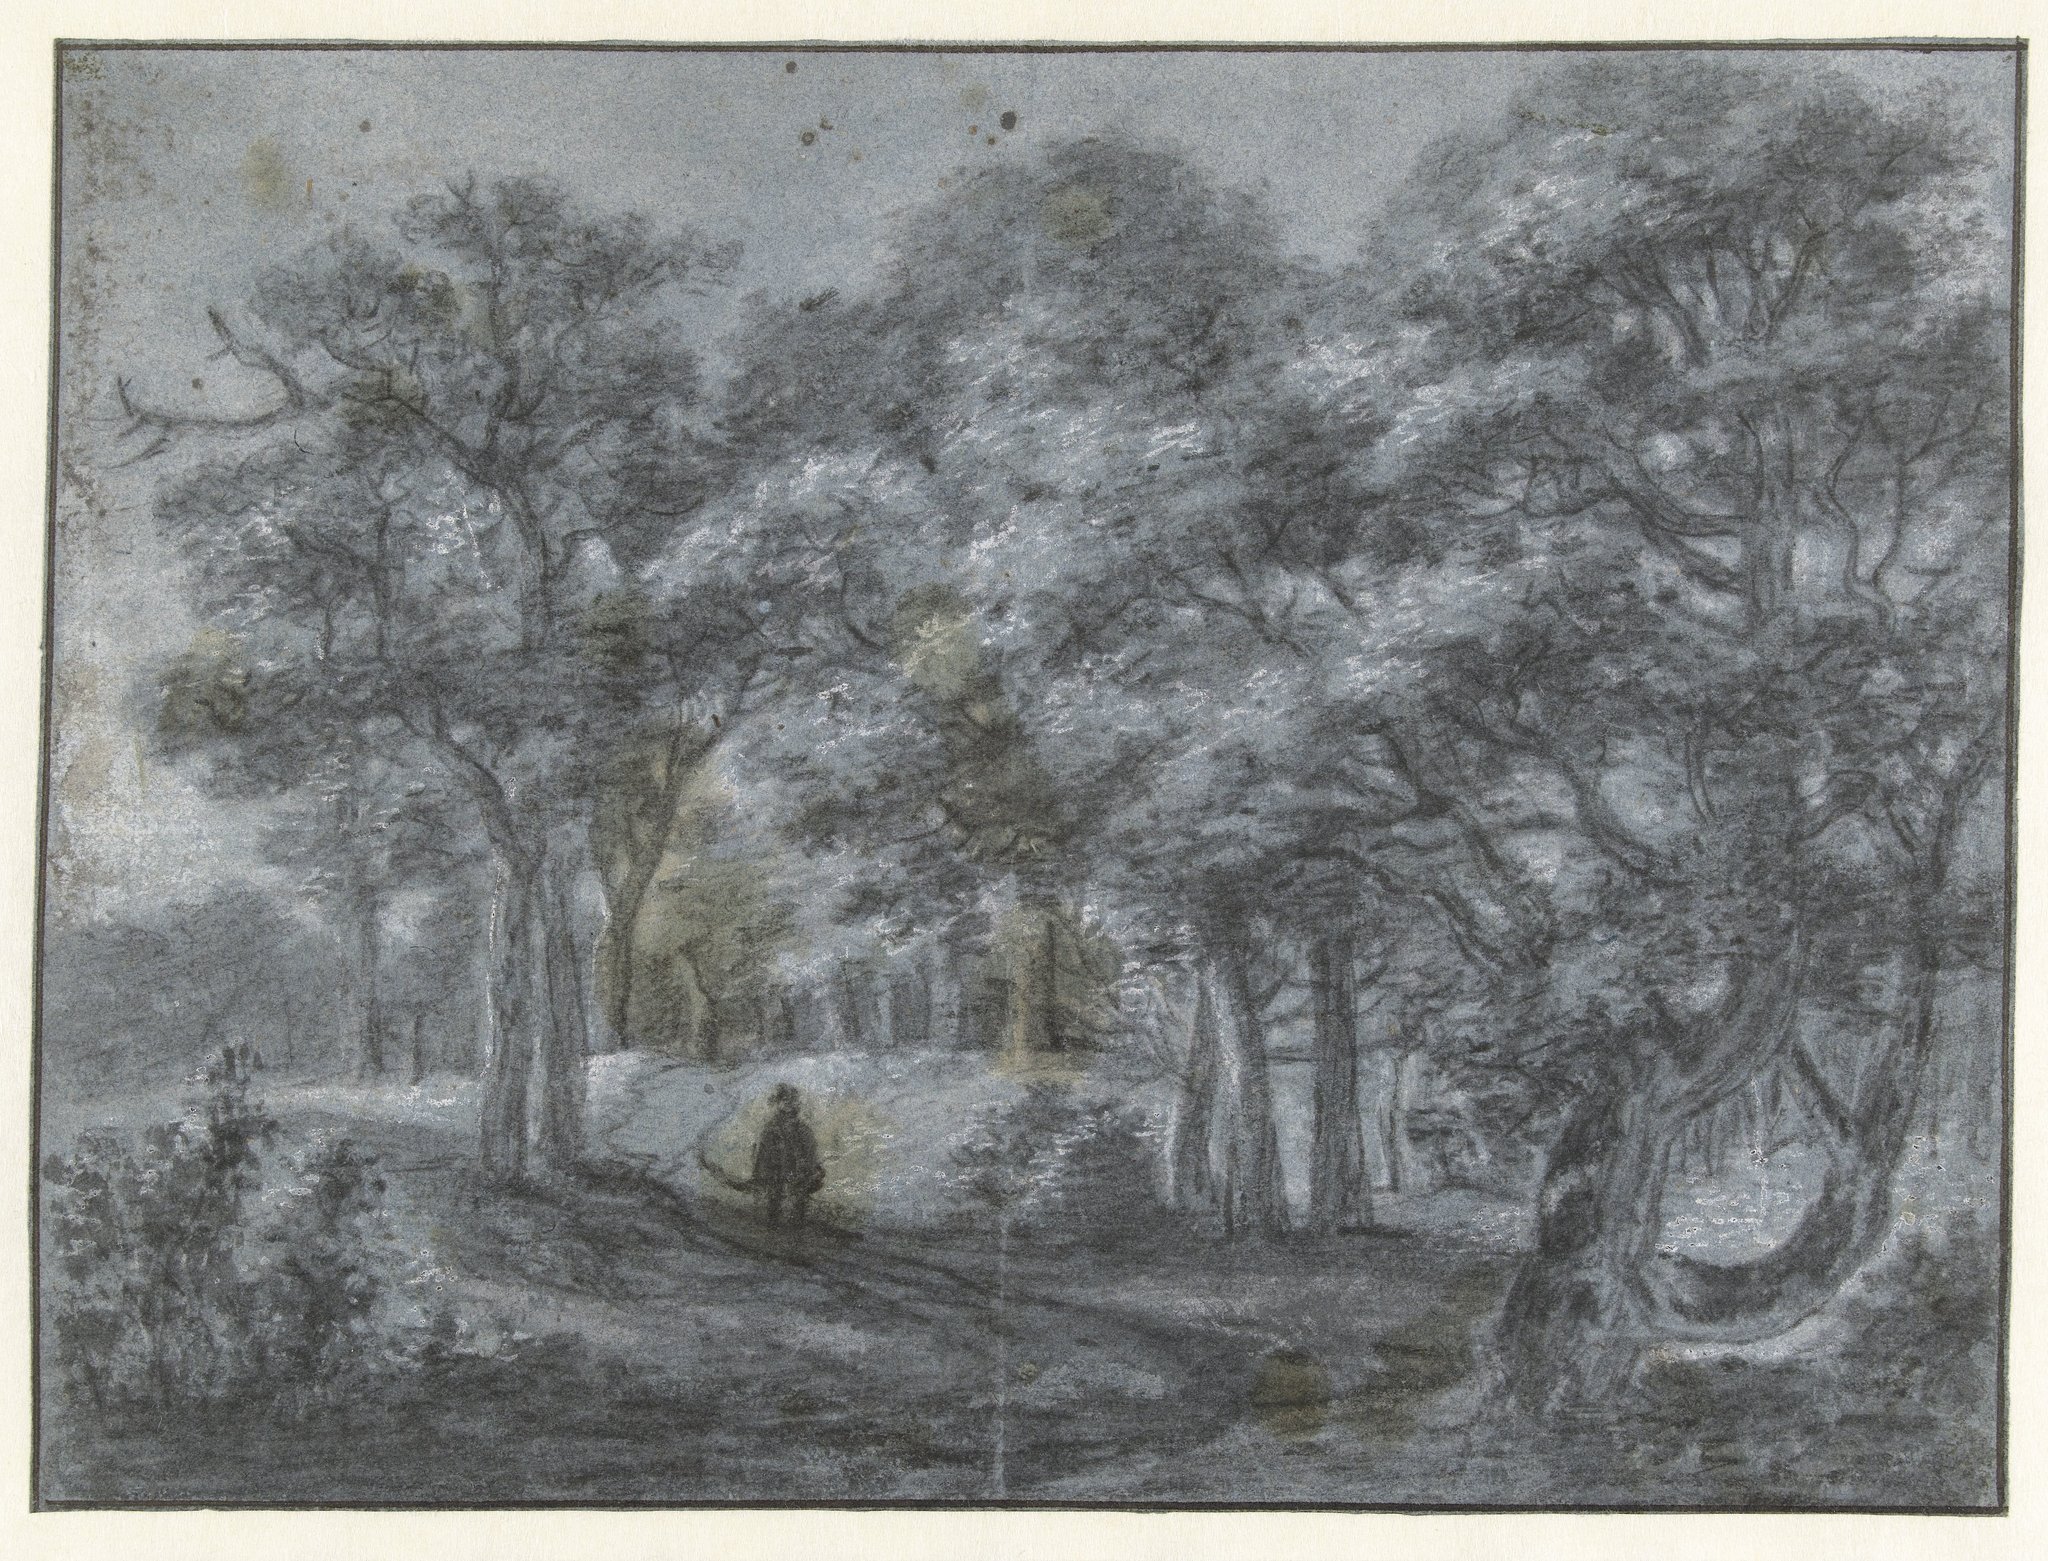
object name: drawing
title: Gezicht in het Haagse bos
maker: simon de vlieger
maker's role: draughtsman, painter, print maker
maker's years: 1600-1653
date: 1610-1653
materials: chalk, paper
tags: forest, wood